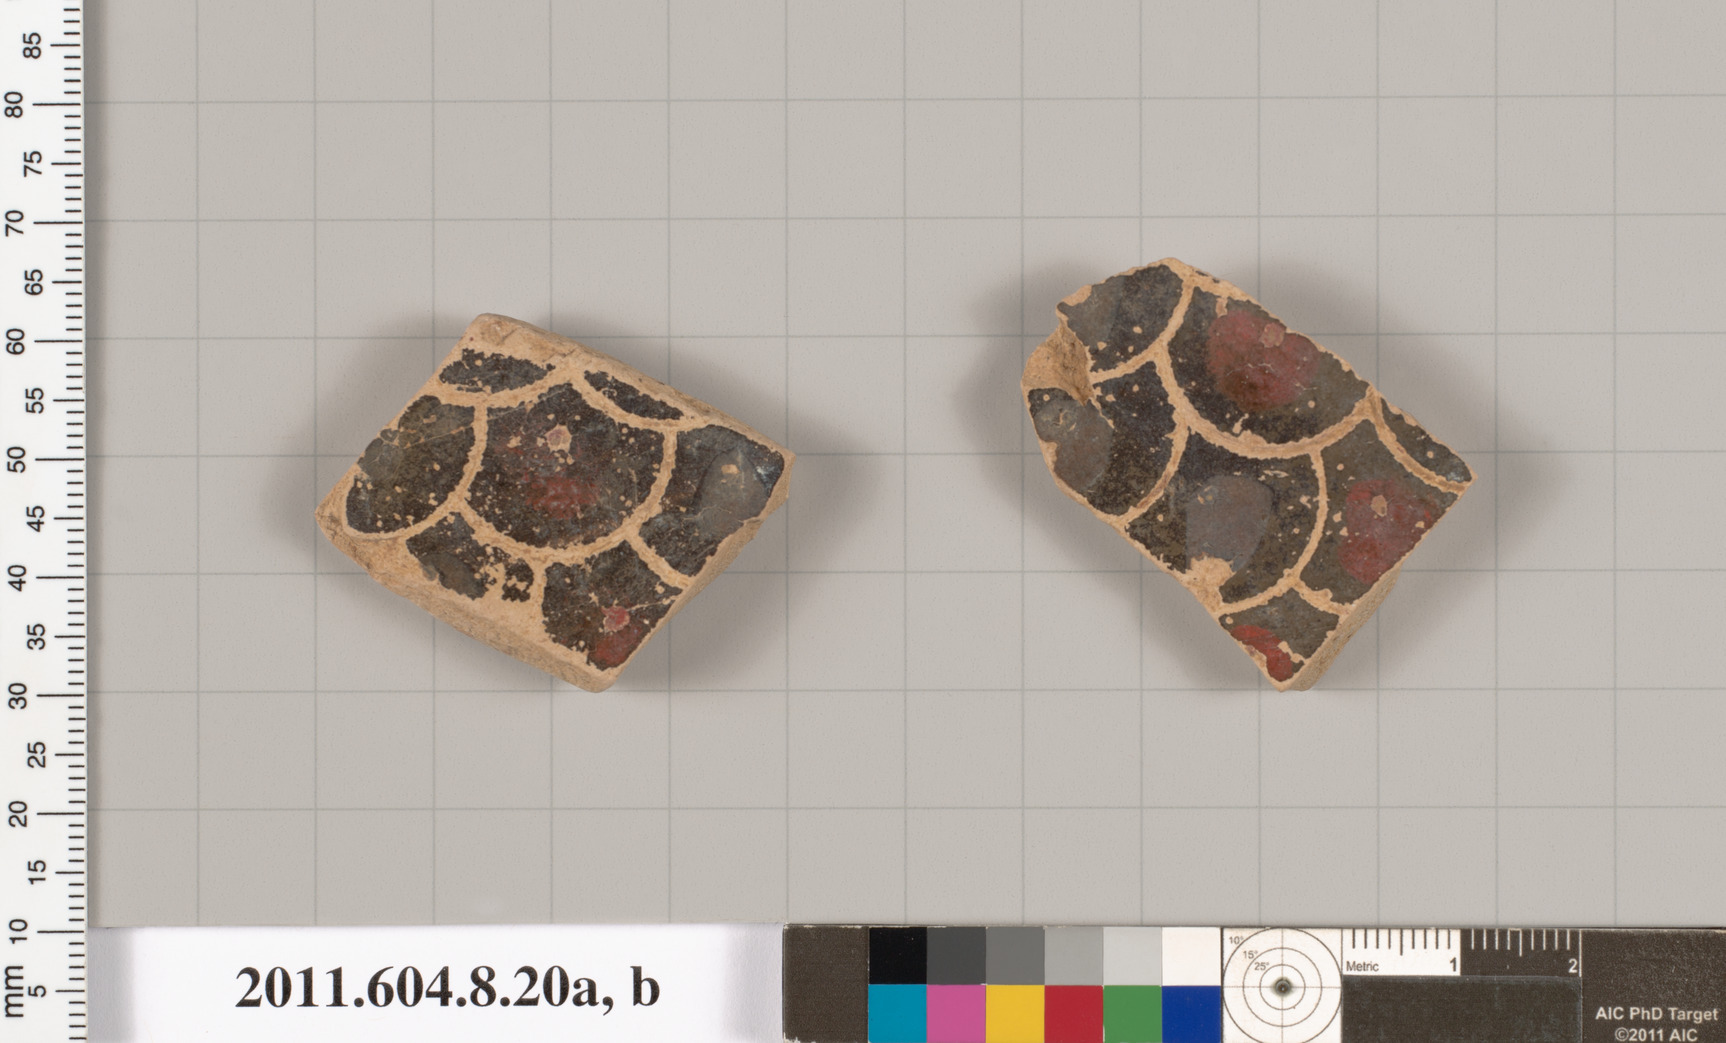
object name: amphora fragment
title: Terracotta fragments of an amphora (jar)?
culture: etruscan, etrusco-corinthian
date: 625-601 BCE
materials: terracotta